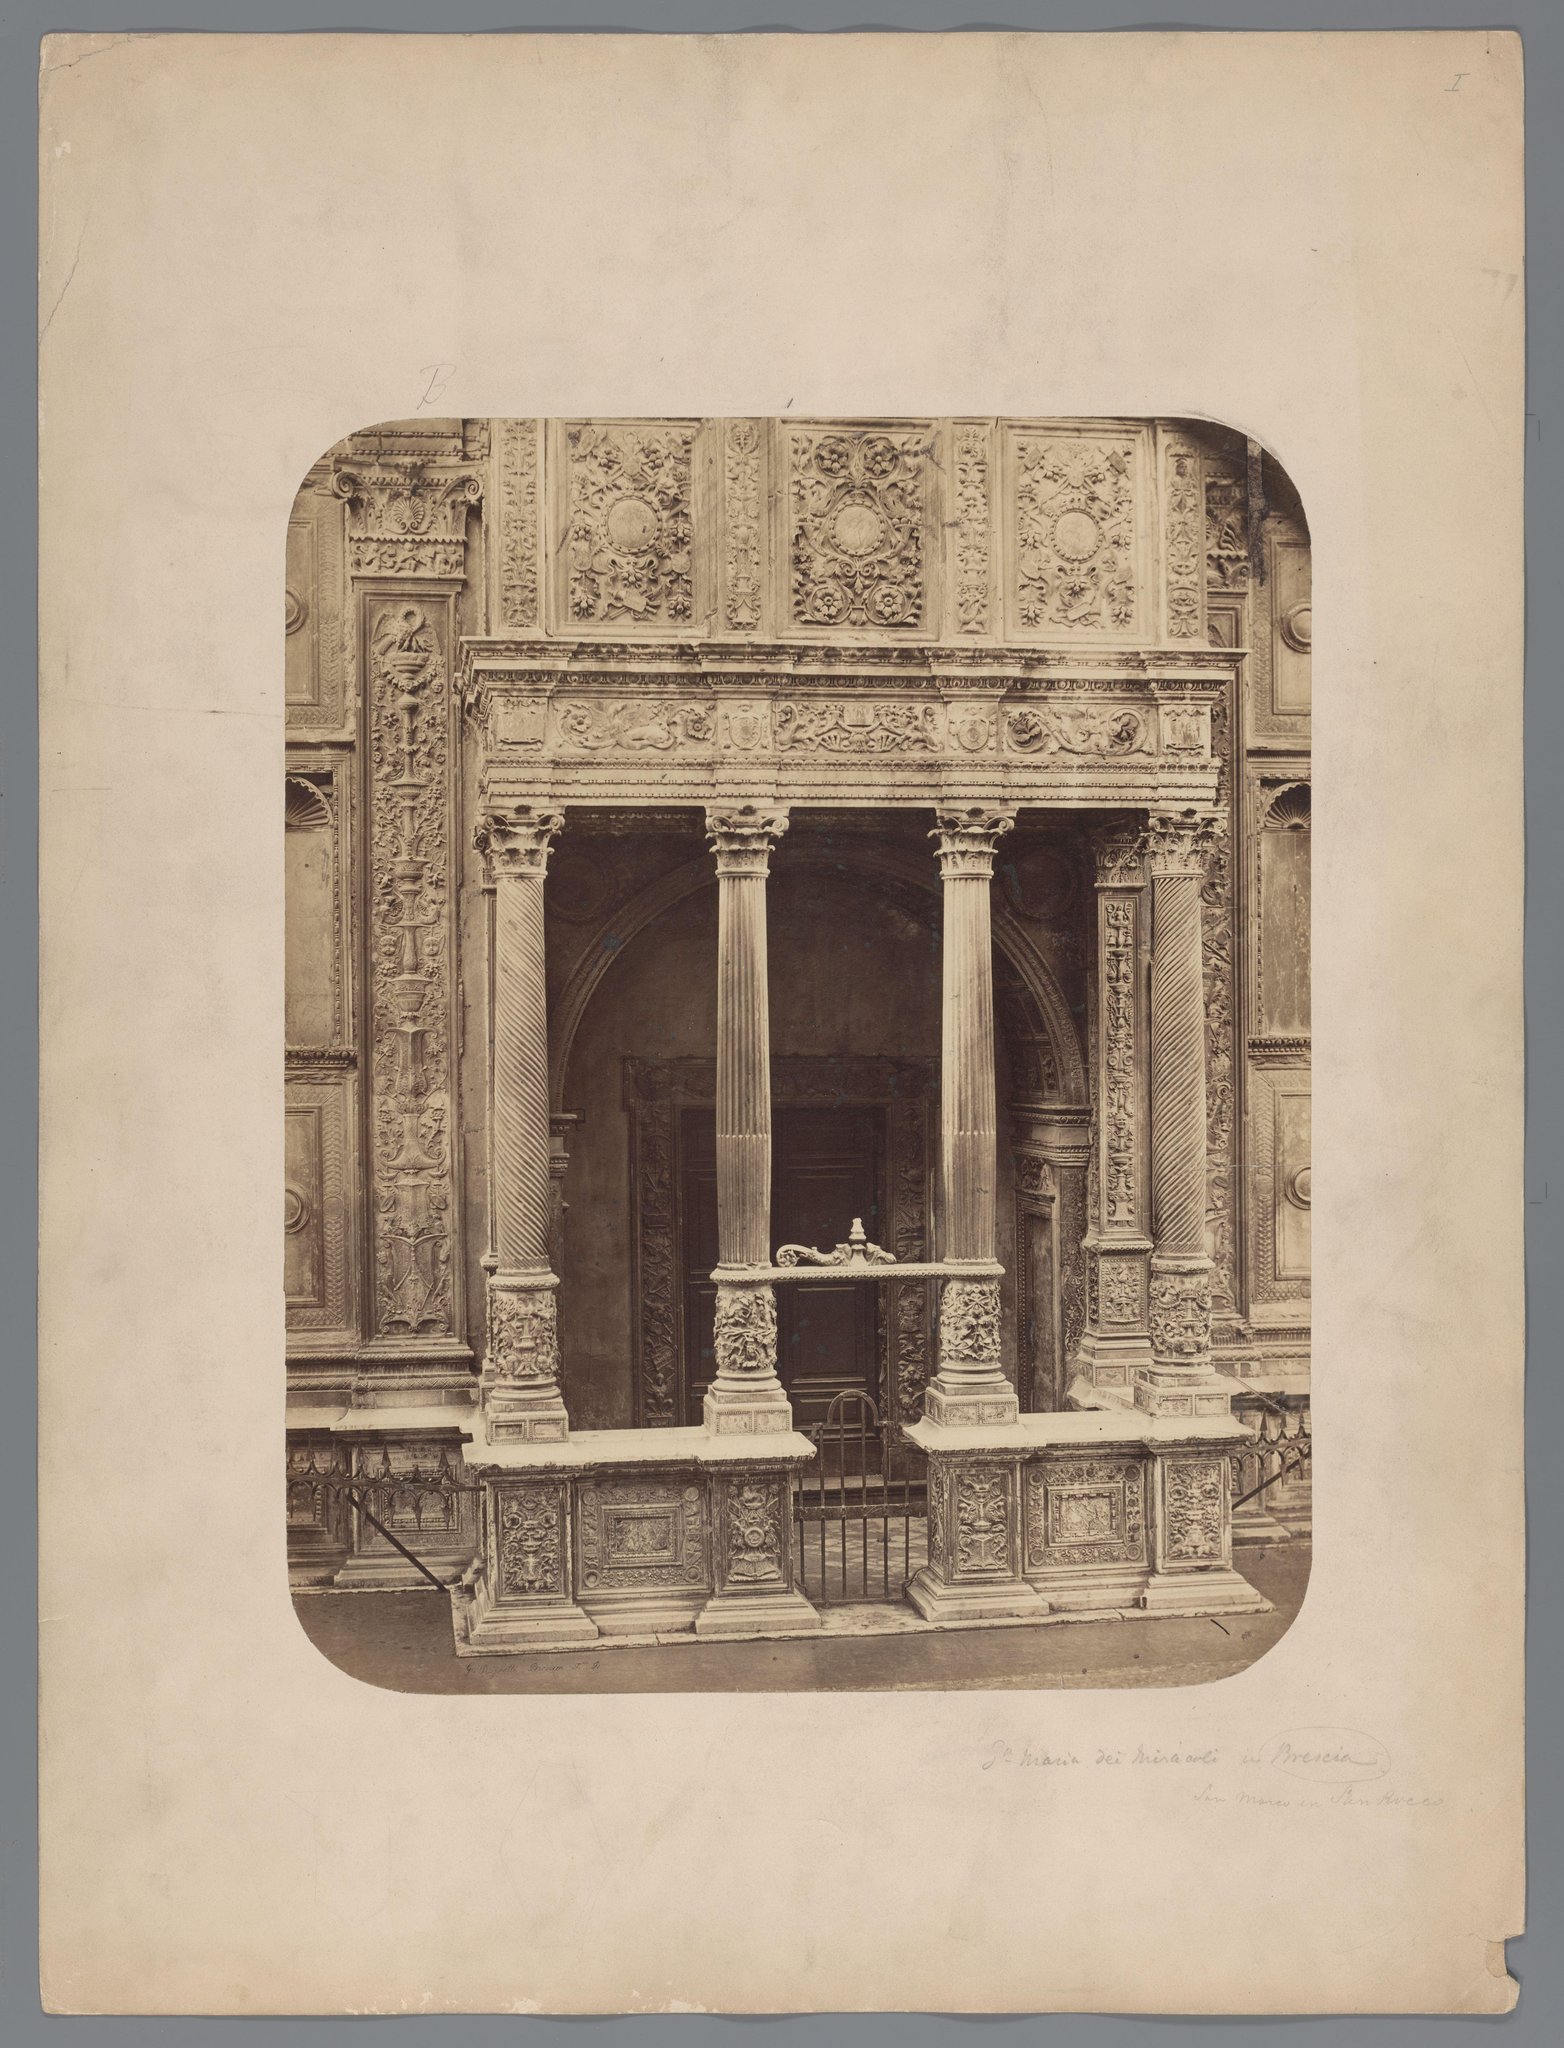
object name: photograph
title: Santa Maria dei Miracoli in Brescia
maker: giacomo rossetti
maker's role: fotograaf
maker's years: 1807-1882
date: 1870-1885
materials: cardboard, paper, photographic support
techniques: albumen print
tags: church (exterior)